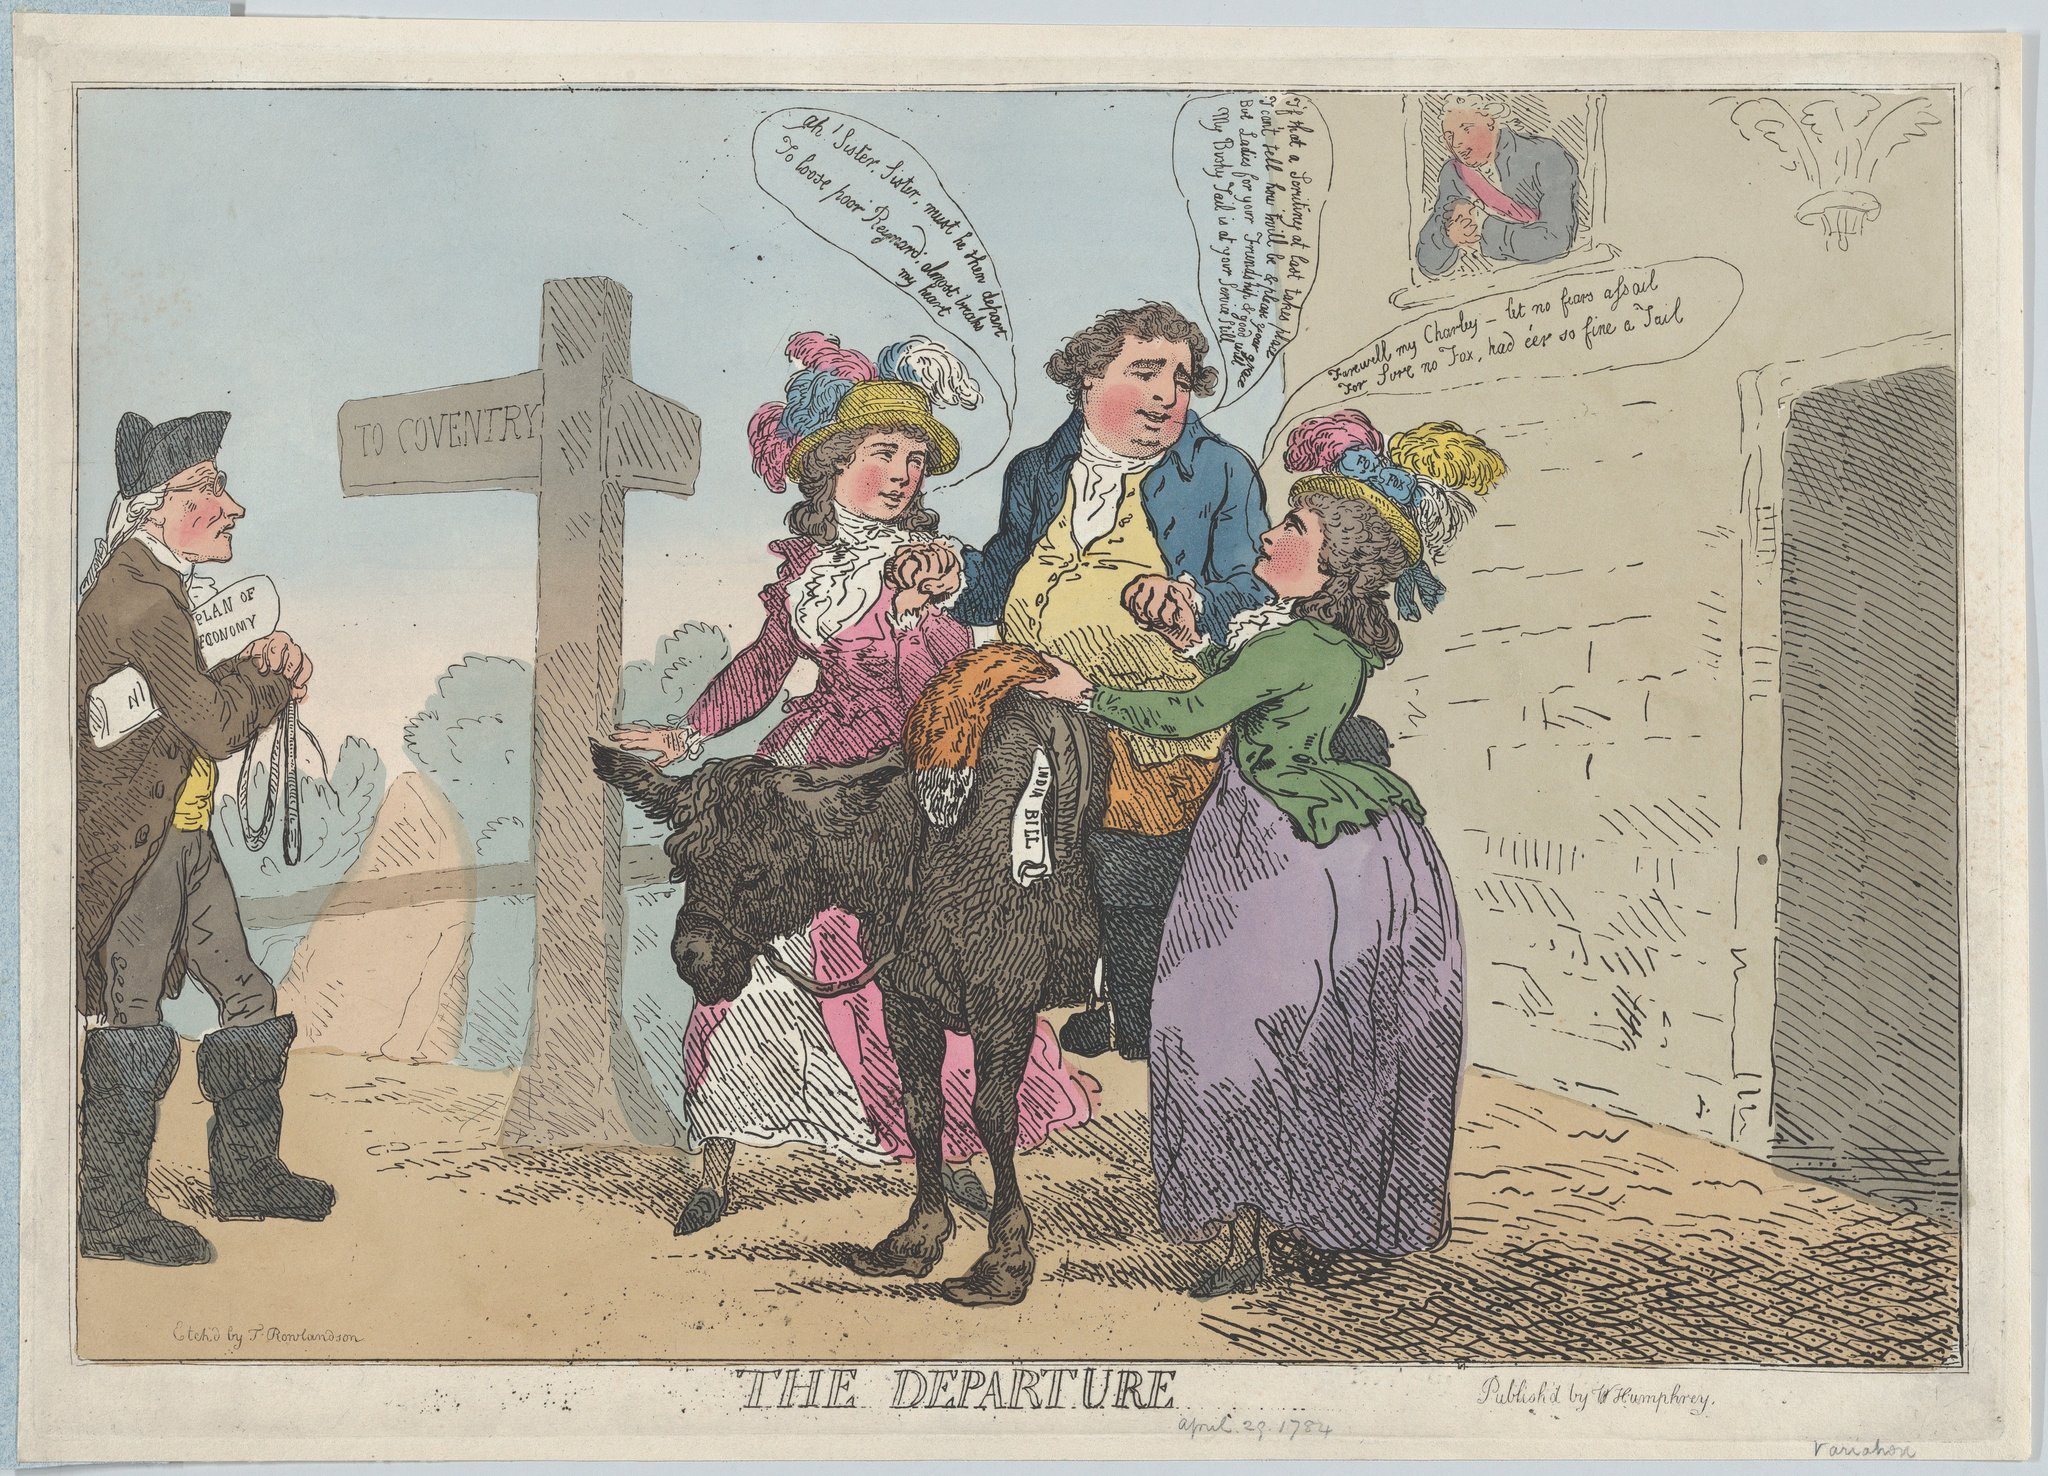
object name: print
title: The Departure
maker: thomas rowlandson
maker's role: artist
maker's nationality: british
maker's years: 1757-1827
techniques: etching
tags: satire,men,women,donkeys,politics